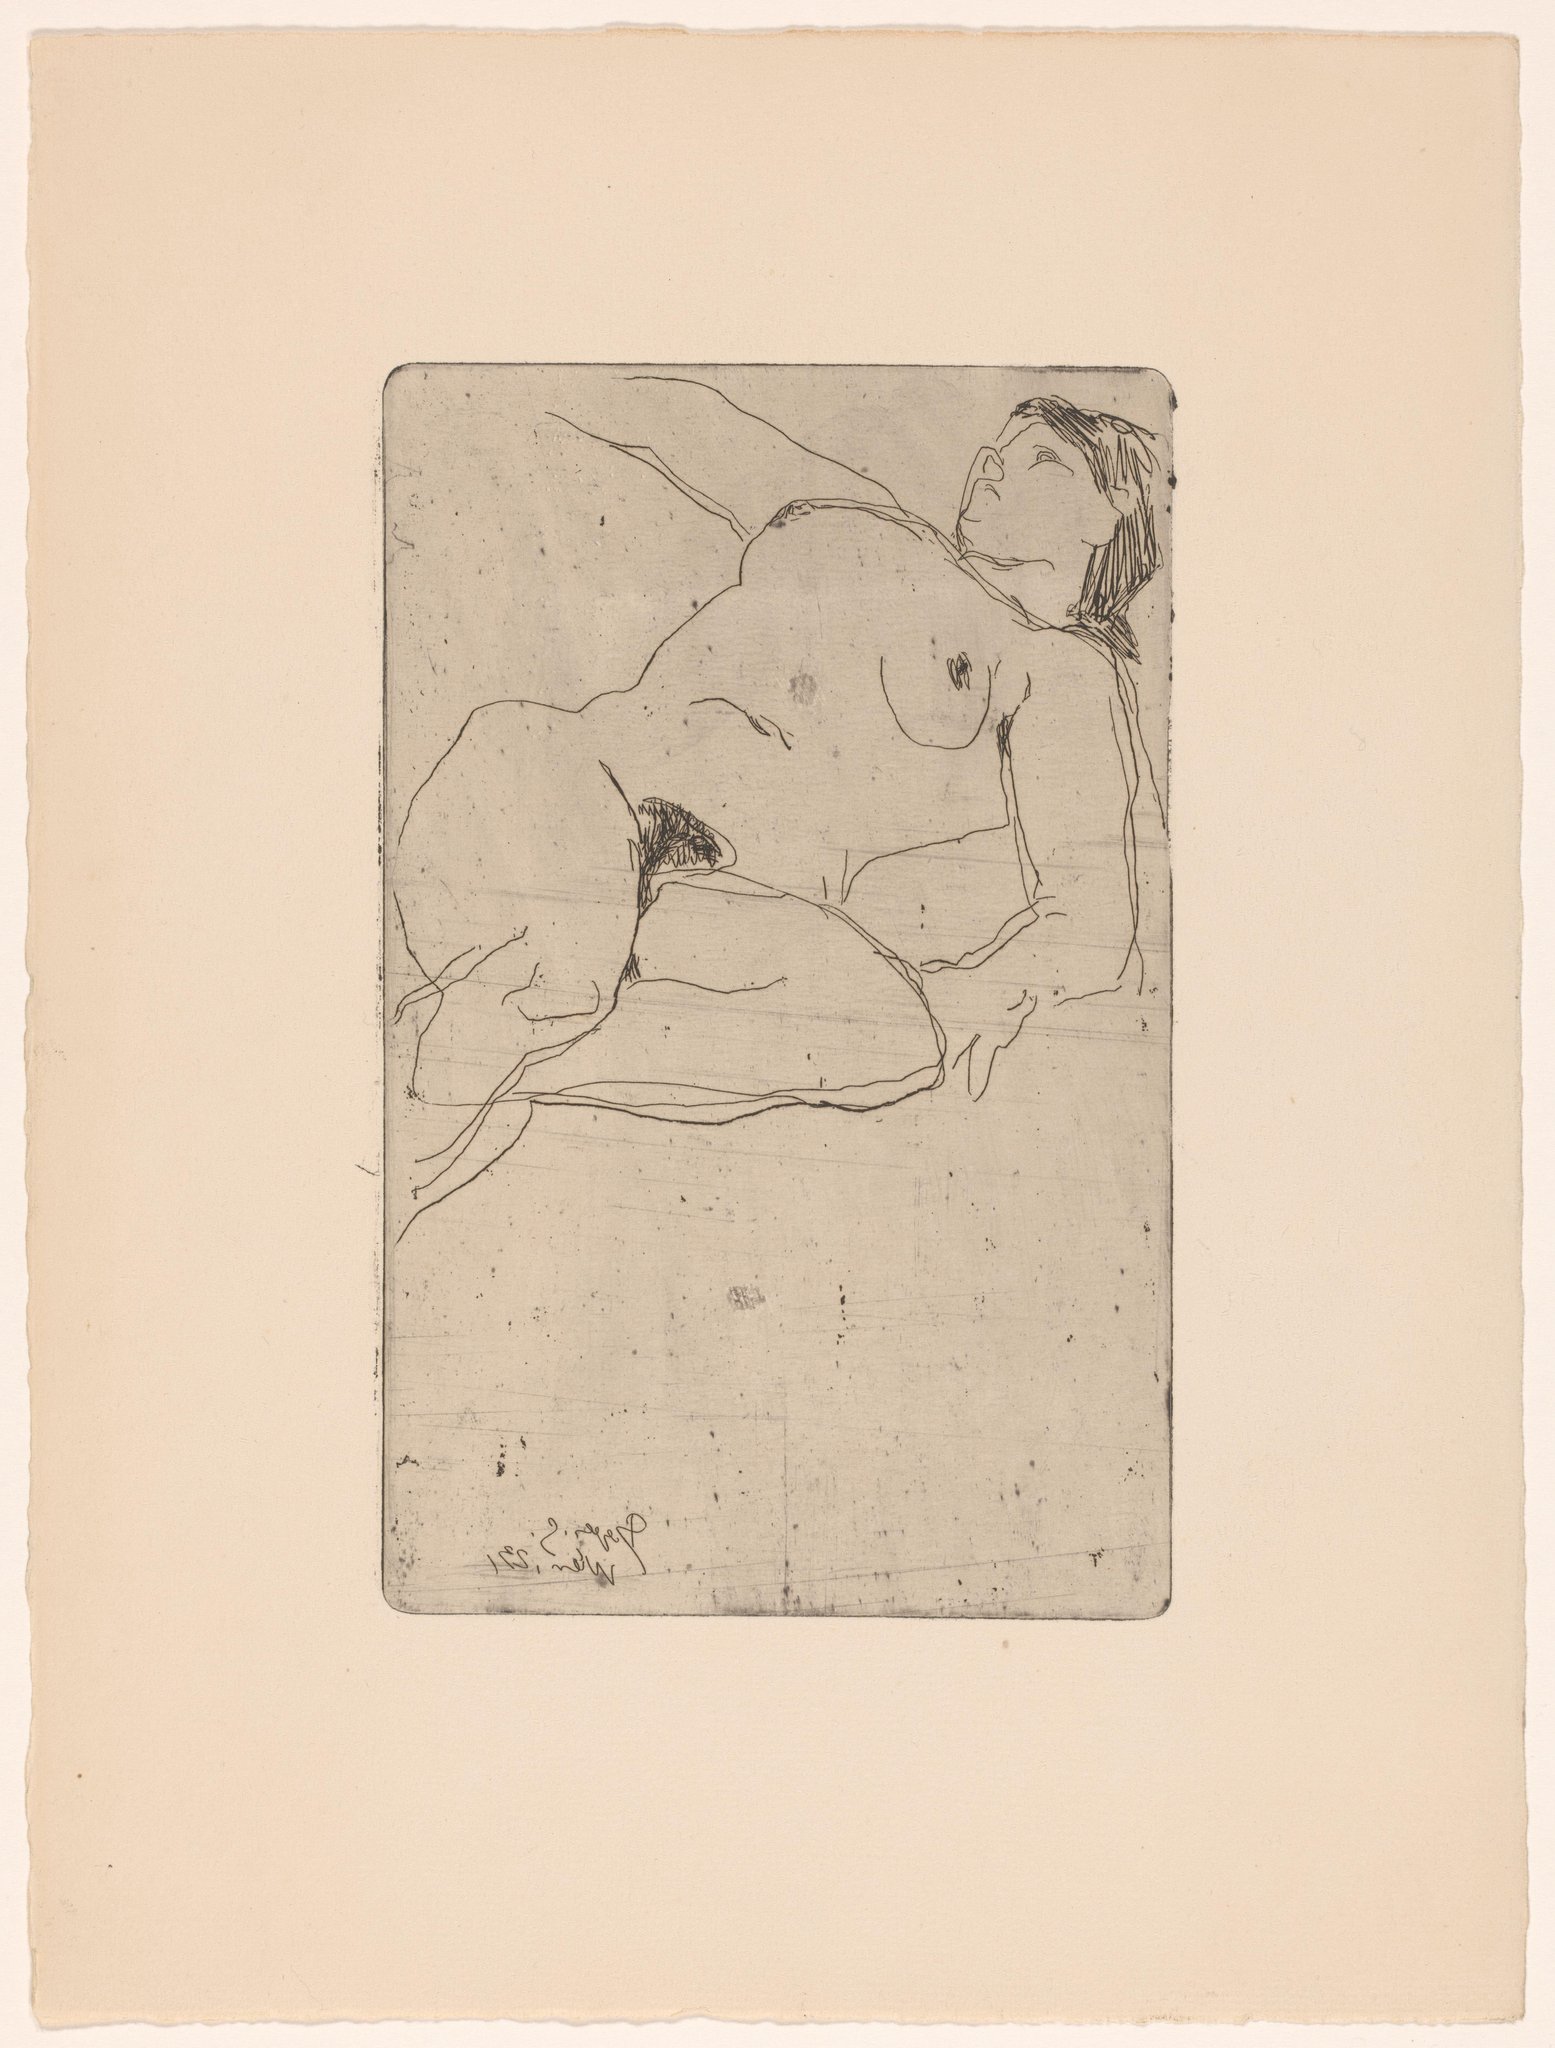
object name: print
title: Liggende naakte vrouw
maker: reijer stolk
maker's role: draughtsman, print maker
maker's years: 1896-1945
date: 1923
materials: paper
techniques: etching, intaglio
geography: netherlands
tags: the (nude) human figure; 'corpo humano' (ripa) - aa - female human figure (+ lying)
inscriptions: collector's mark: Lugt 2228